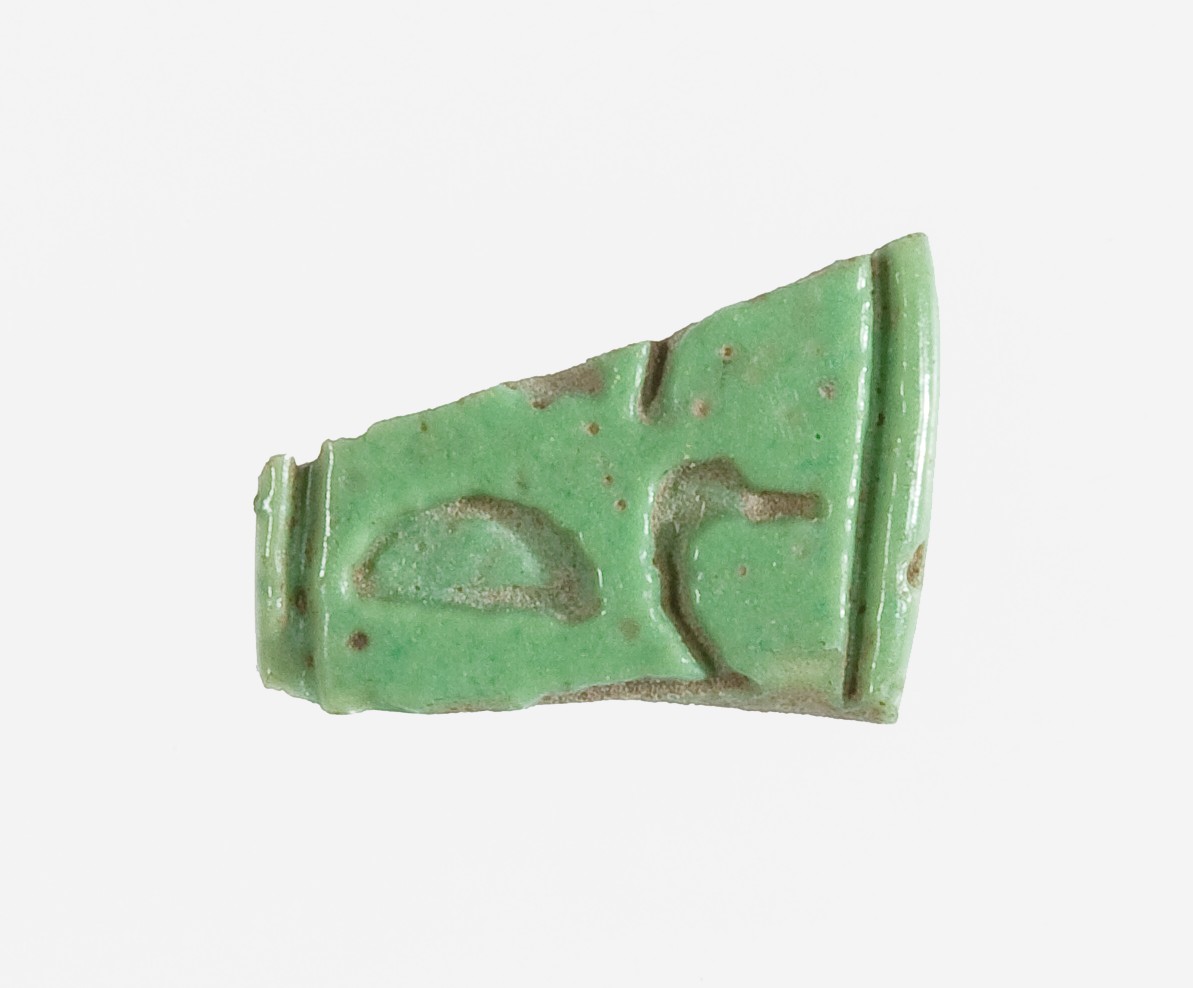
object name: ring fragment, sitamun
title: Ring fragment with part of the name Sitamun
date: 1390-1352 BCE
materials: faience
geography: egypt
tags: hieroglyphs